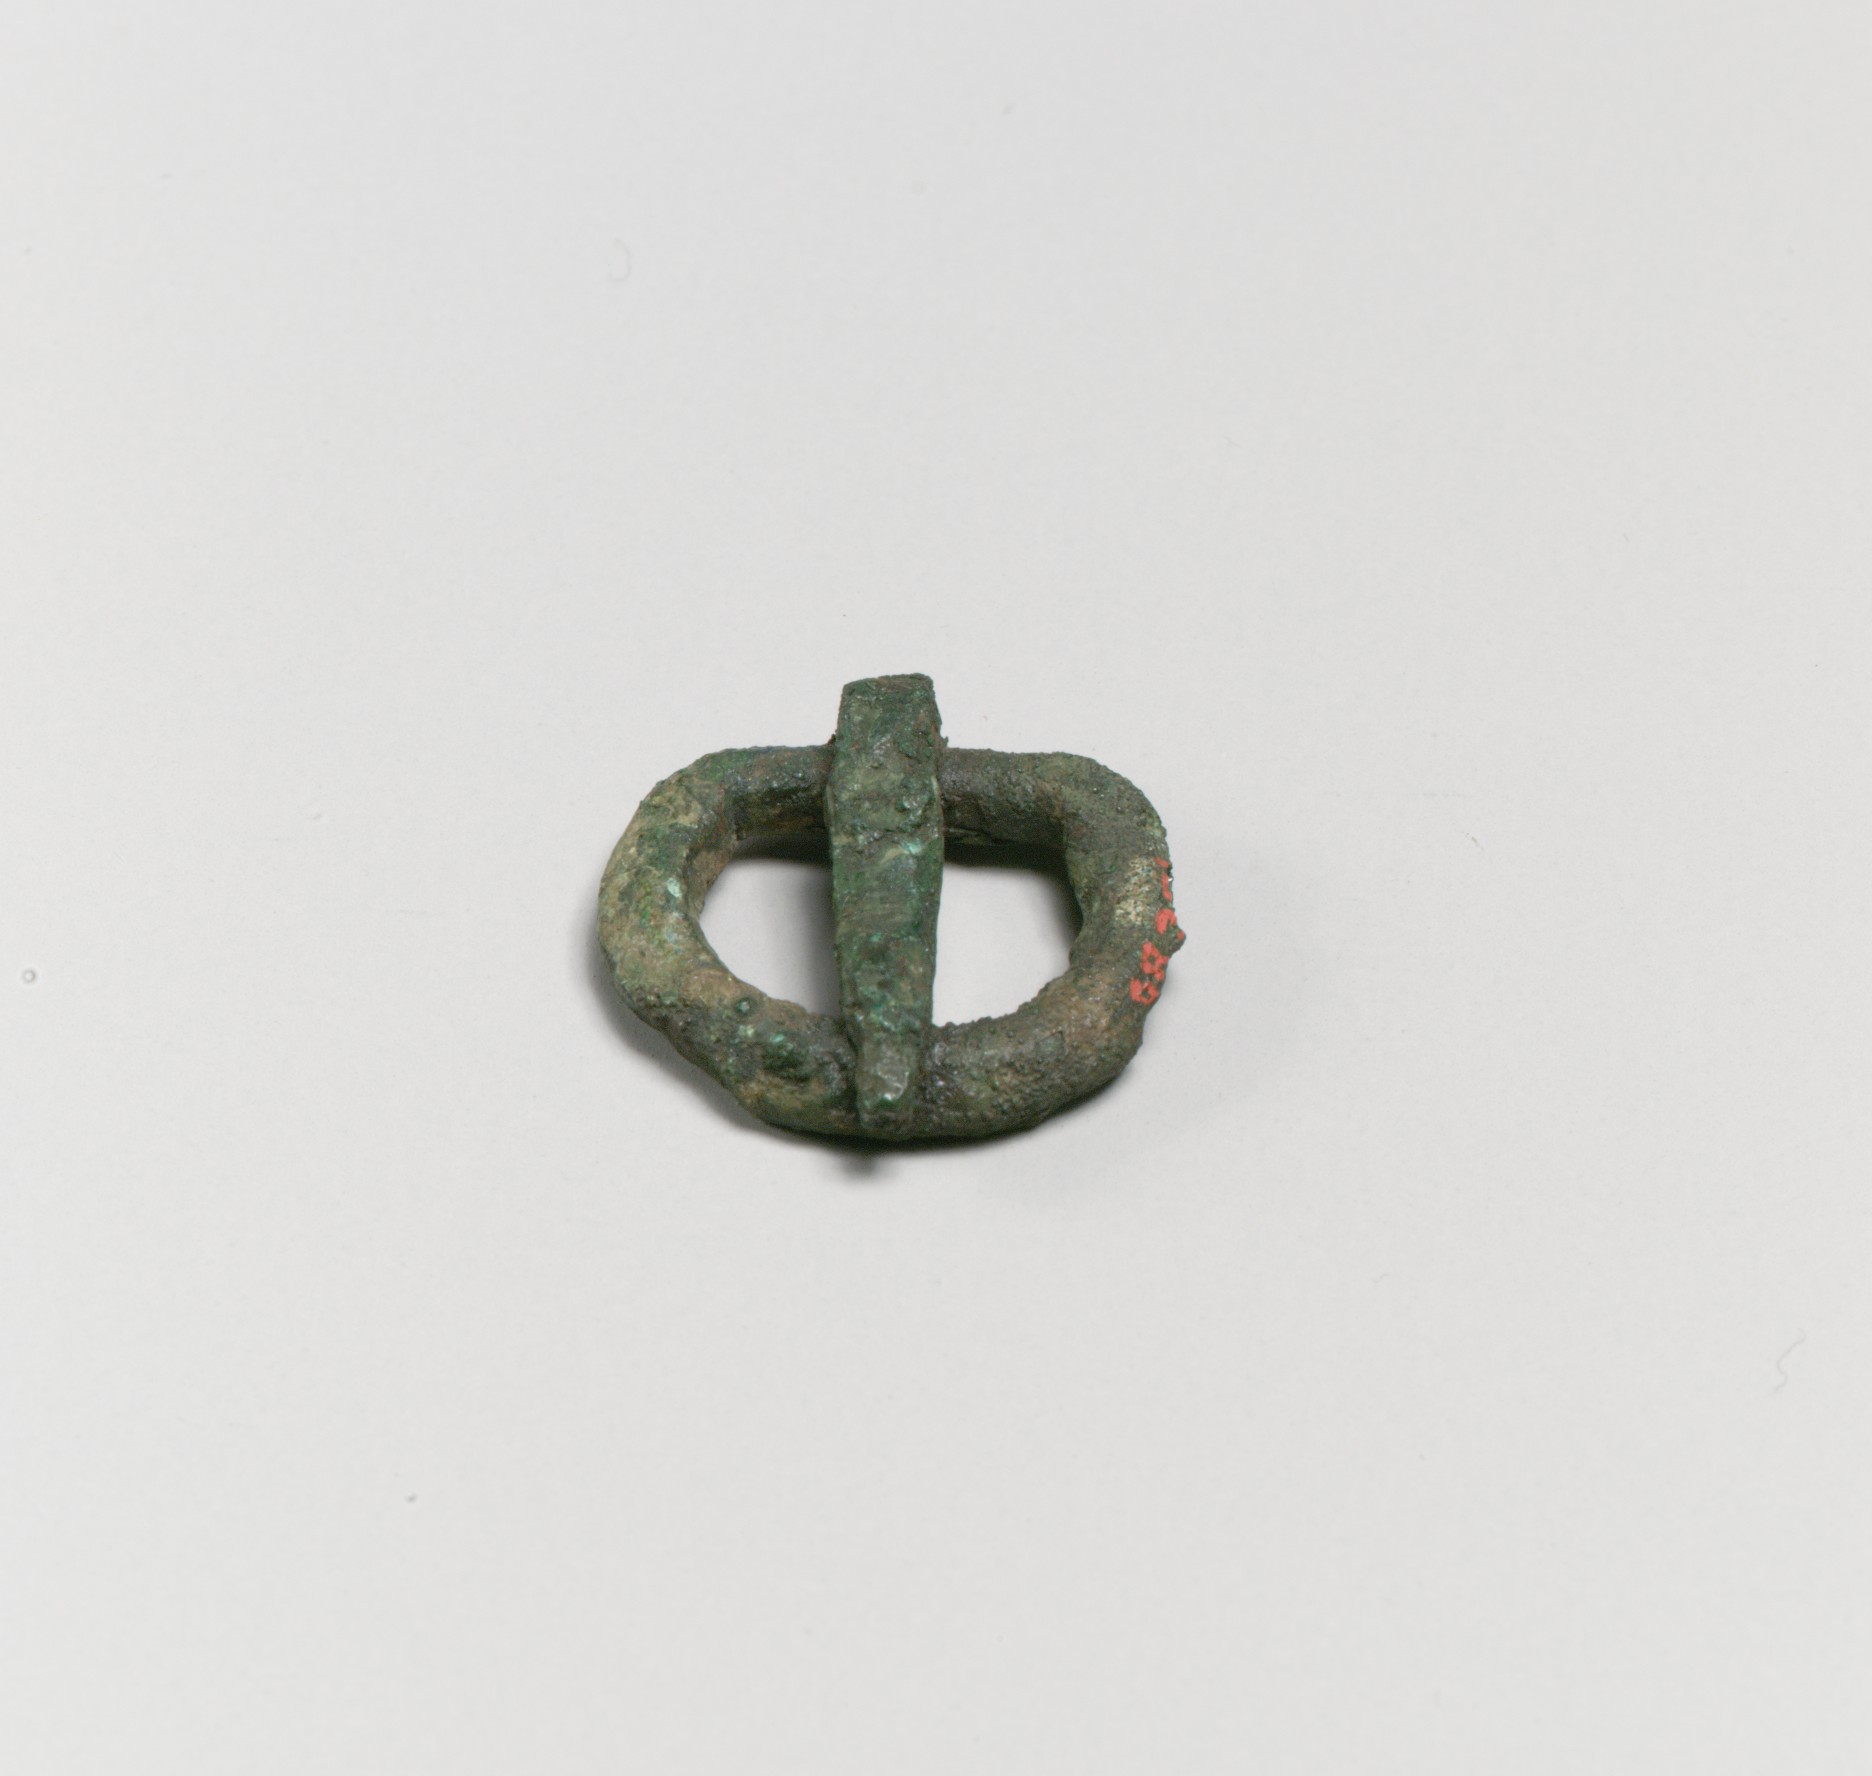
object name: buckle fragment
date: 7000 BCE-330 CE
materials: bronze